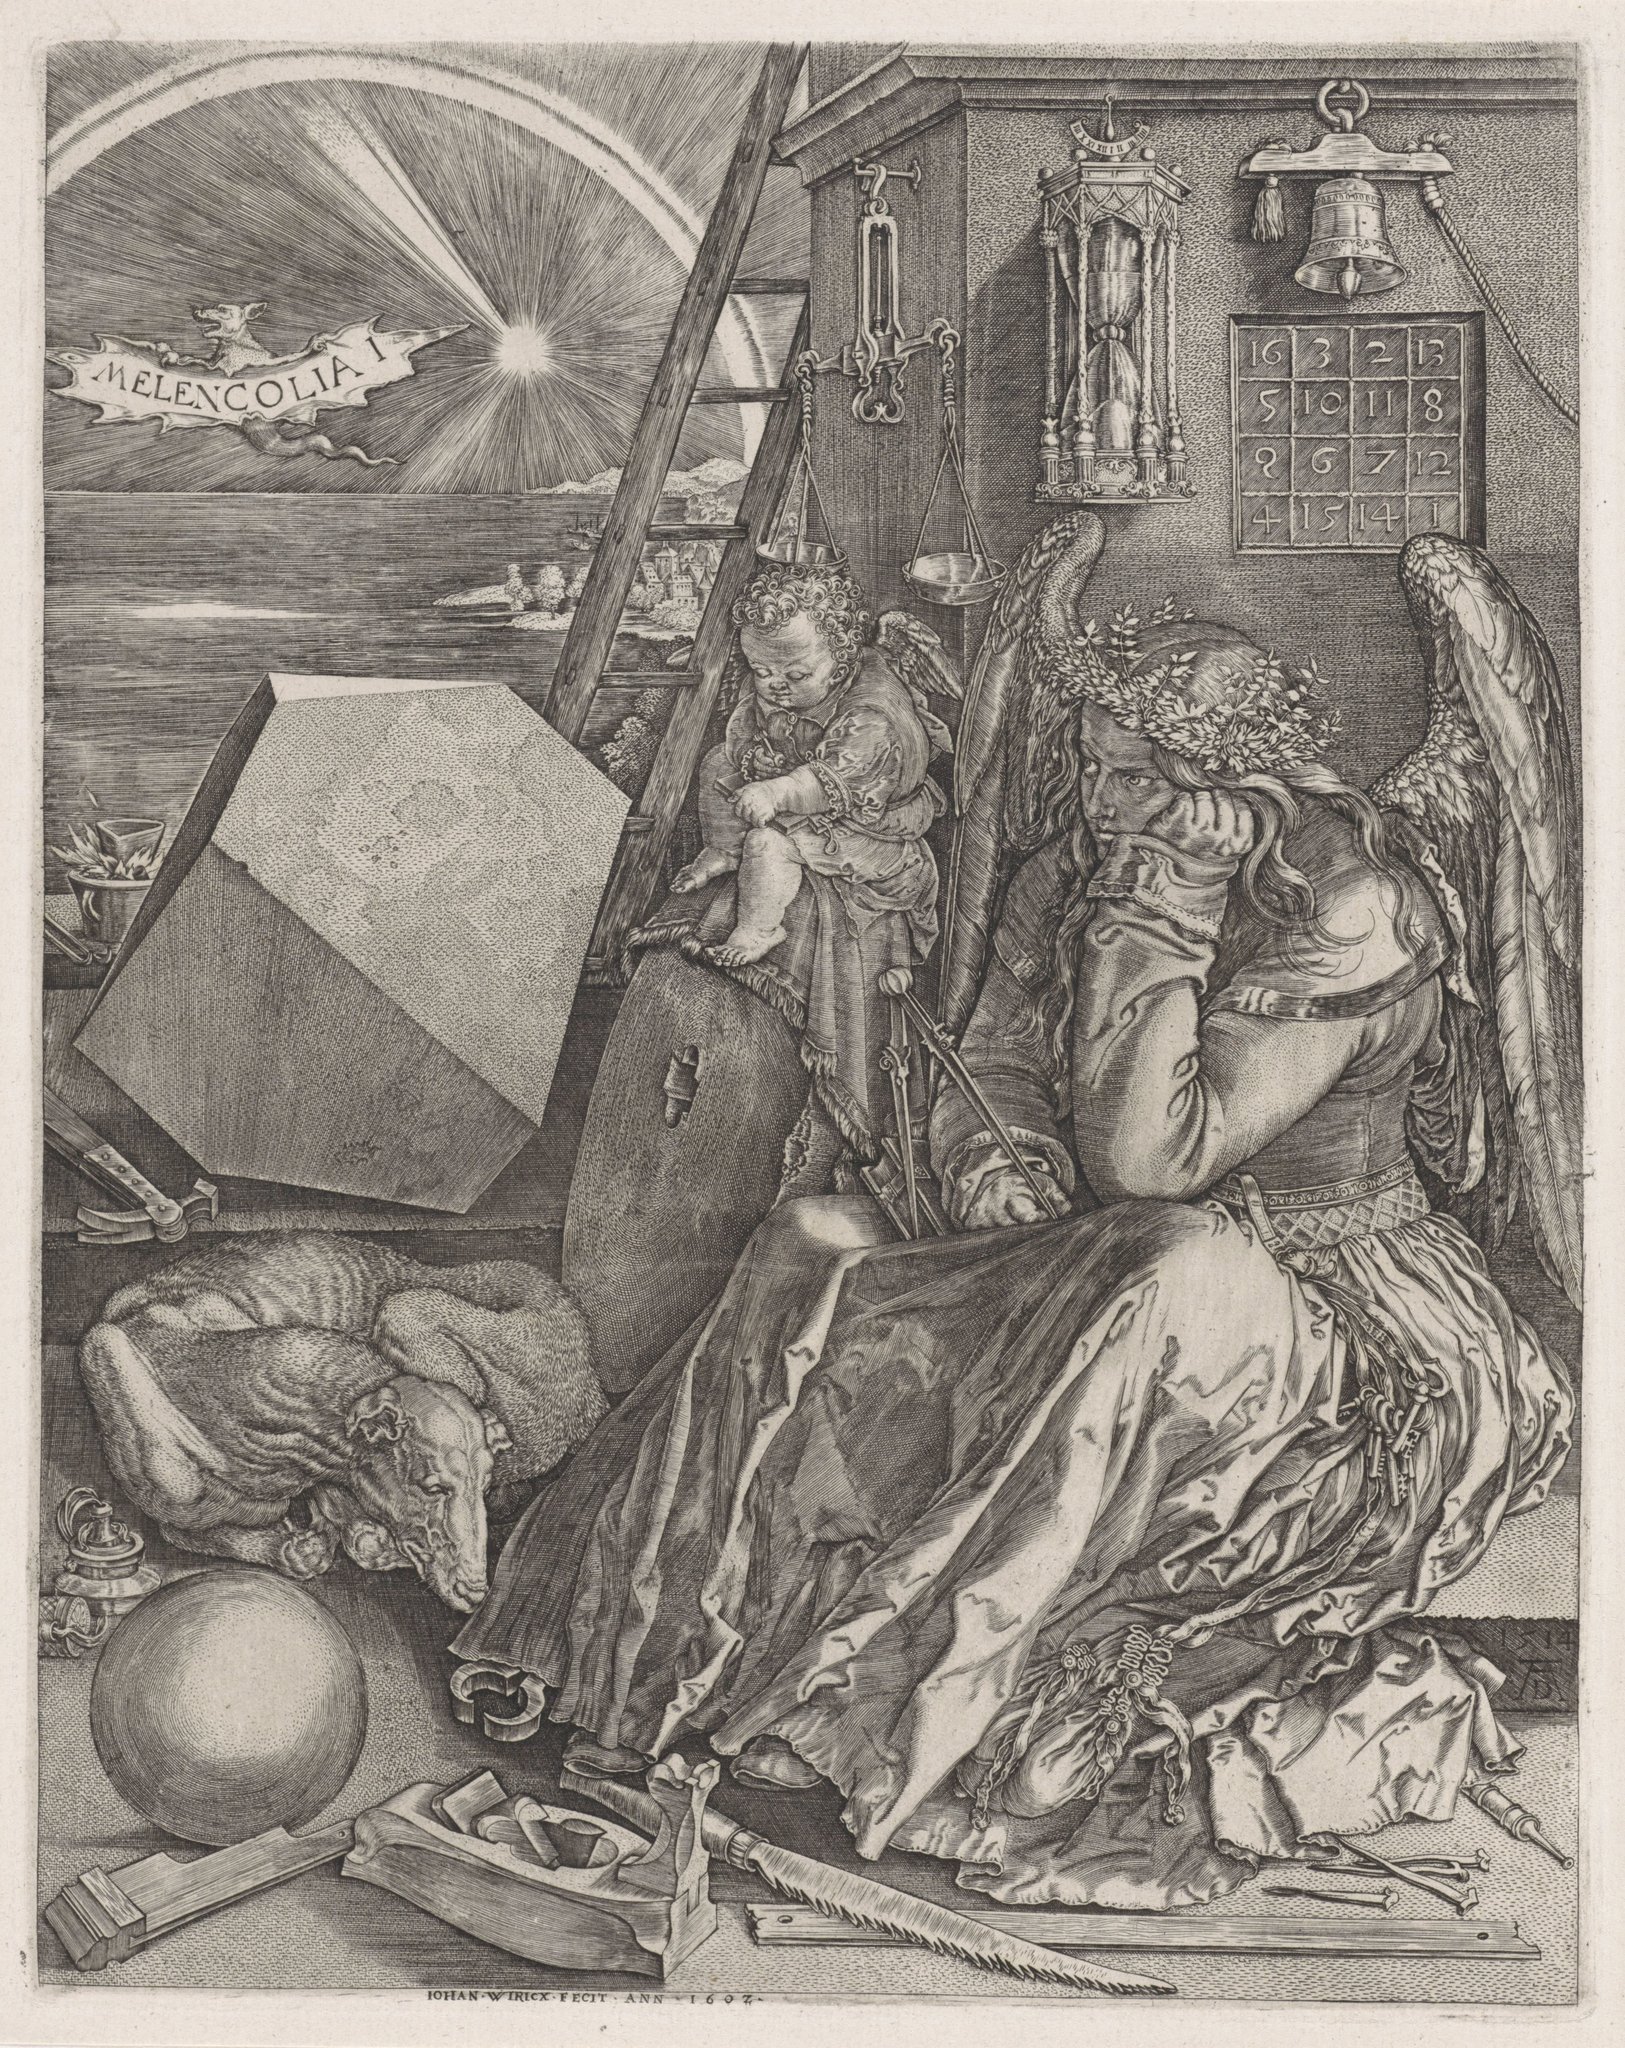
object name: print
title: Melancholie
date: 1602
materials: paper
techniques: engraving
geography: antwerp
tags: melancholic temperament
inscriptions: collector's mark: Lugt 2228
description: Het melancholische temperament in de gedaante van een gevleugelde vrouw die peinzend voor zich uitkijkt, de kaak op de linkerhand gesteund, een passer in de hand. Om haar heen diverse (meet)instrumenten, zoals een weegschaal, een zandloper en een zaag. Aan haar voeten een hond. Naast haar een putto die iets op een tablet schrijft. Rechtsonder op een steen het monogram van Albrecht Dürer en de datering van diens prent.